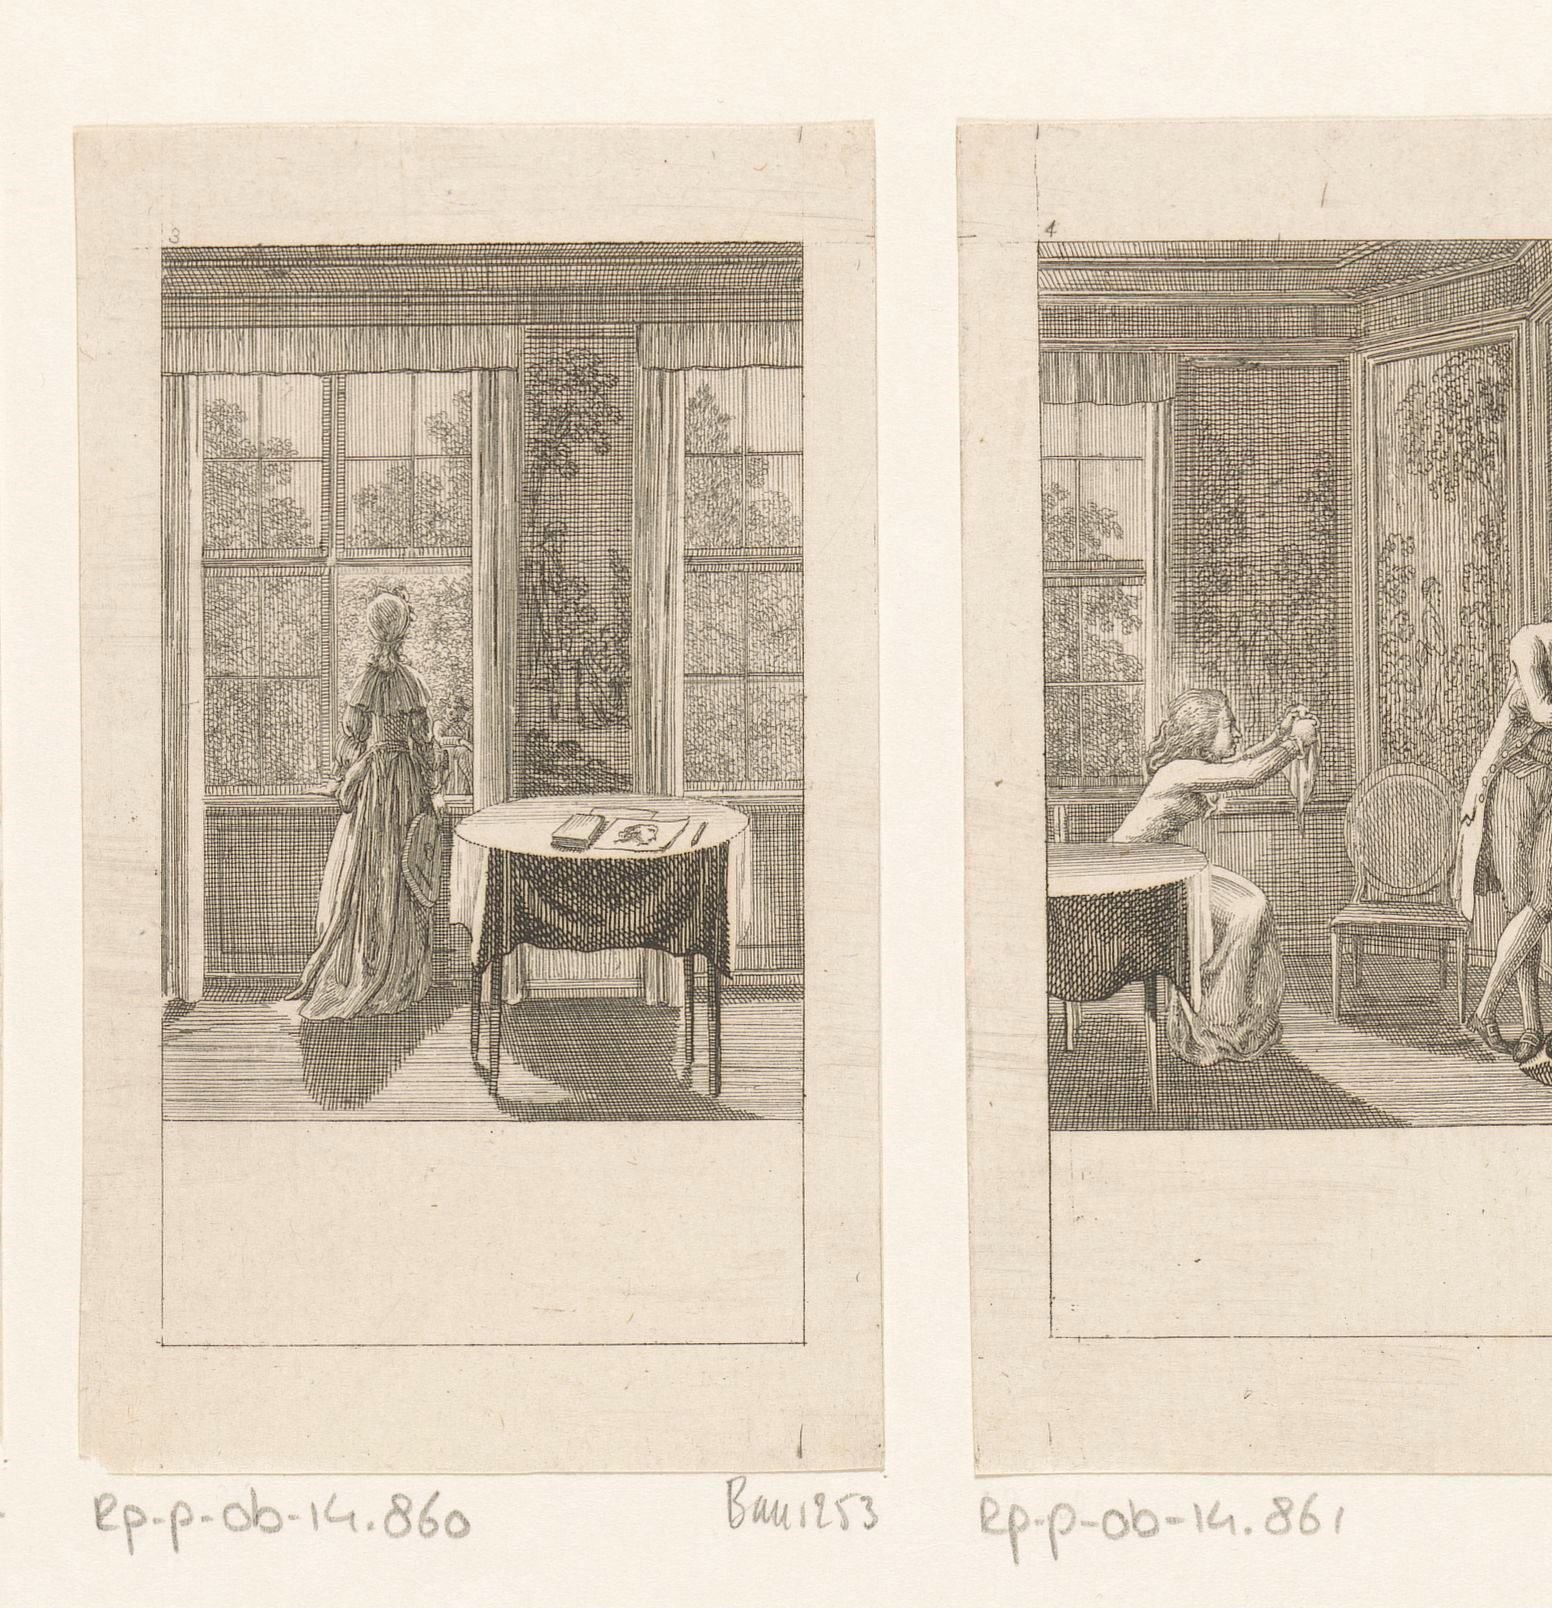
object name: print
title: Baron Lindorf brengt een serenade aan het raam van Caroline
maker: daniel nikolaus chodowiecki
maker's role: draughtsman, print maker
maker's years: 1726-1801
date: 1786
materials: paper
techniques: etching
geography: berlin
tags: literature, human figure at (open) window, seen from inside - aa - feigned window, serenade to the beloved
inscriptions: collector's mark: Lugt 2228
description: Vervaardigd voor 'Caroline von Lichtfield' van Isabelle de Montolieu. Latere staat gebruikt voor: Gothaischer Hof Kalender zum Nutzen und Vergnügen eingerichtet auf das Jahr 1788. Gotha: C. W. Ettinger, [1787].